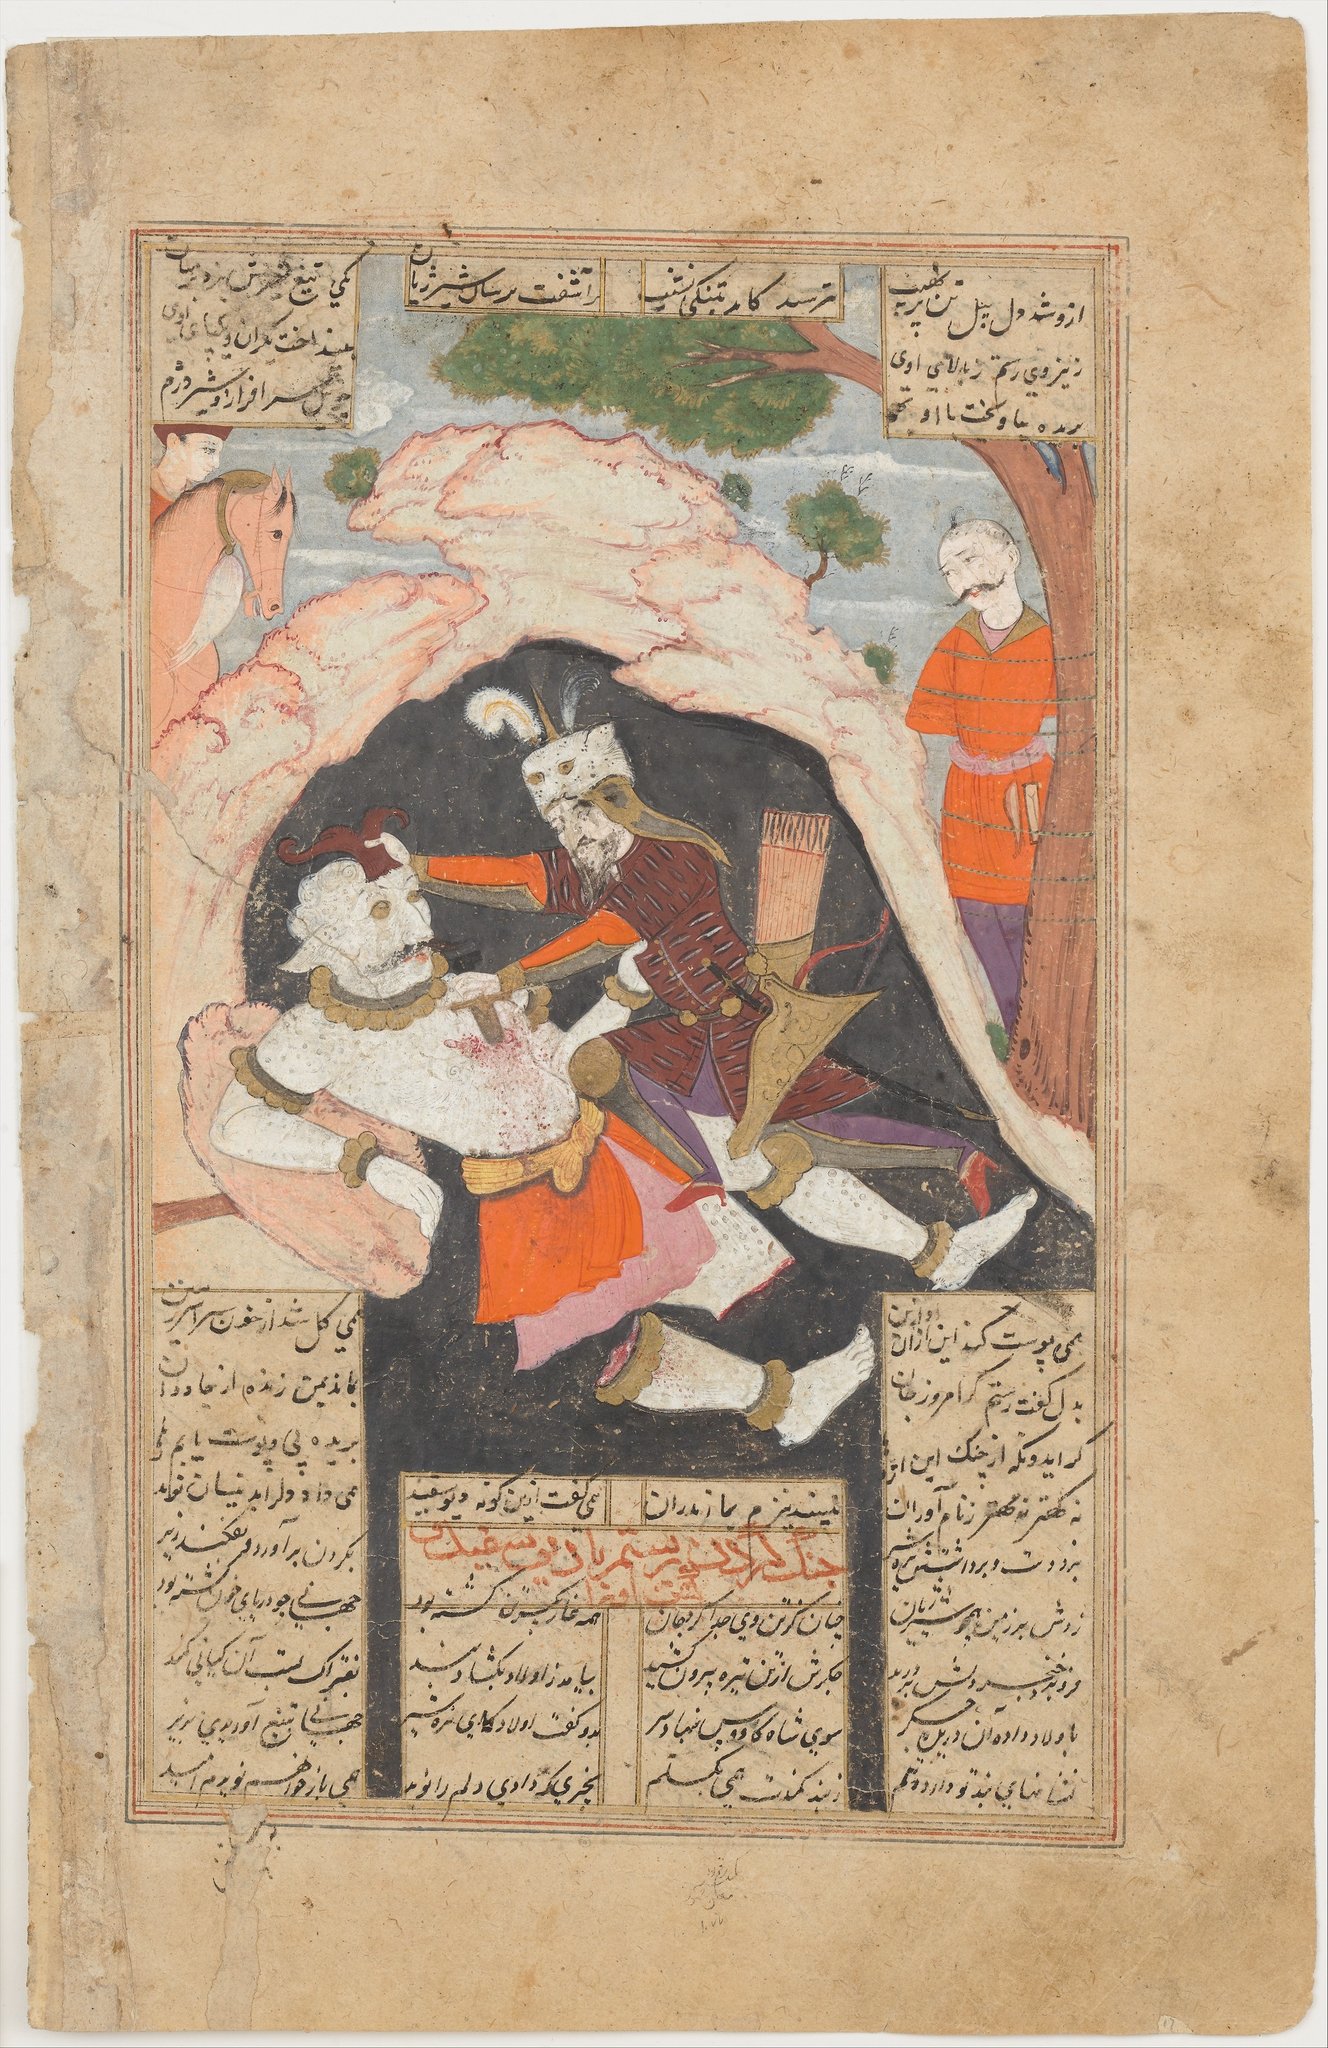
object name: folio from an illustrated manuscript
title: "Rustam's Seventh Course: He Kills the White Div", Folio from a Shahnama (Book of Kings)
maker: abu'l qasim firdausi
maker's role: author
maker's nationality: iranian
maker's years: 935-1020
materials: gold, ink, paper, silver, watercolor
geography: iran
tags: weapons,men